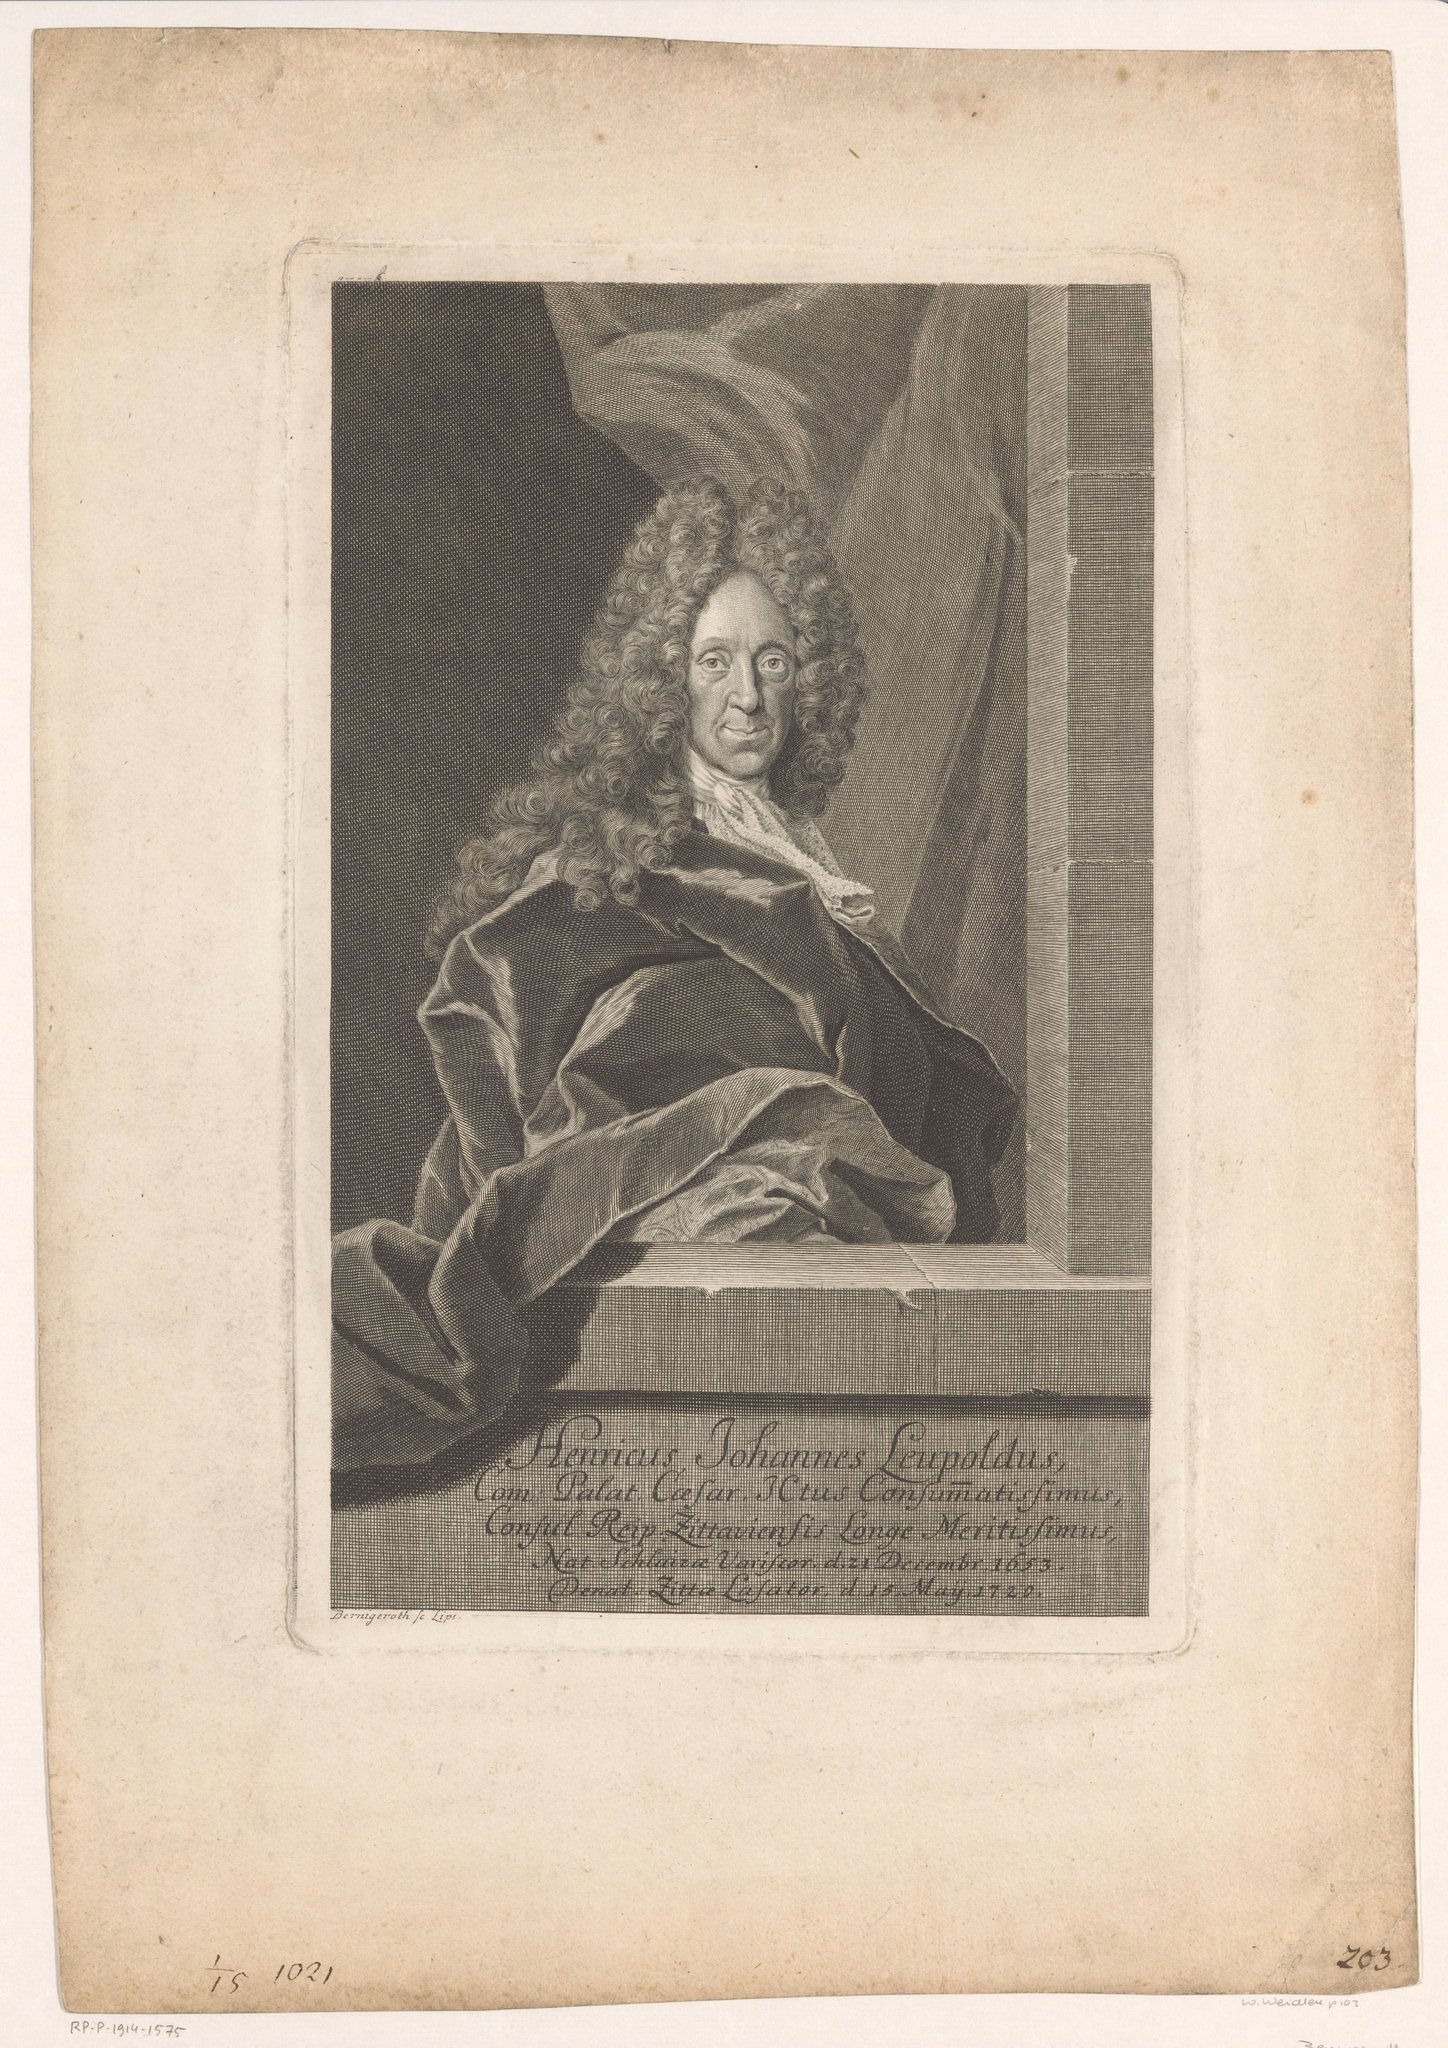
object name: print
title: Portret van Heinrich Johann Leupold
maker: martin bernigeroth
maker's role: print maker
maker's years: 1670-1733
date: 1720-1733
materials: paper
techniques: engraving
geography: leipzig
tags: earl, mayor, historical persons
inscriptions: collector's mark: Lugt 357, collector's mark: Lugt 2228